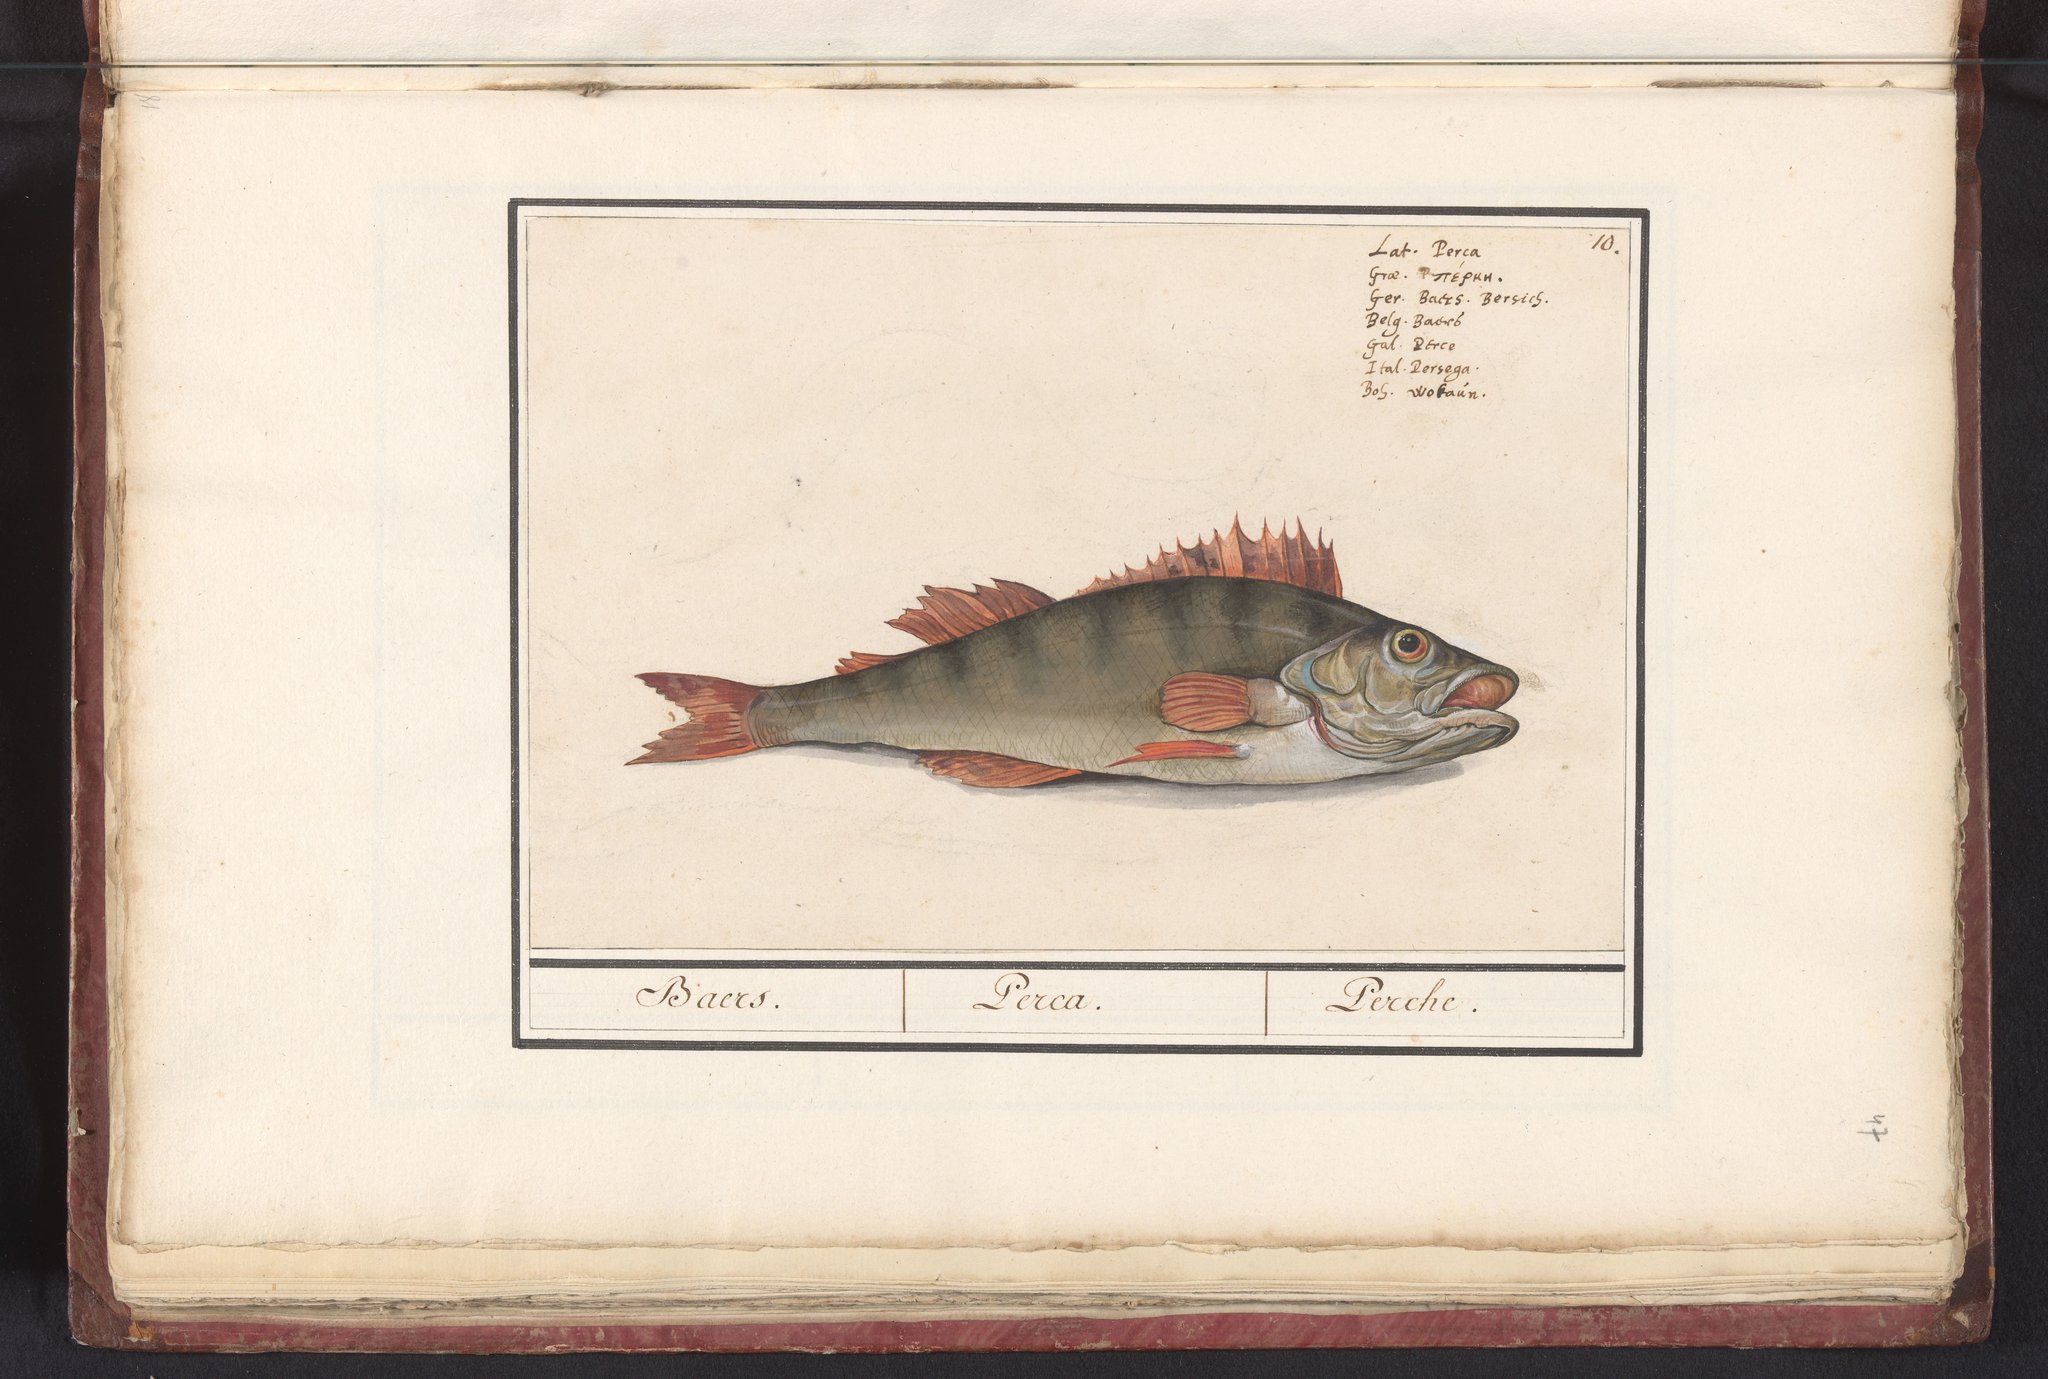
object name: drawing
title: Baers. / Perca. / Perche.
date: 1596-1610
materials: chalk, paint, ink, lacquer, paper, pencil, watercolor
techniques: brush, pen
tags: bony fishes: perch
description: Baars. Genummerd rechtsboven: 10. Hier ook de naam in zeven talen. Onderdeel van het zesde album met tekeningen van vissen, schelpen en insekten. Zesde van twaalf albums met tekeningen van dieren, vogels en planten bekend rond 1600, gemaakt in opdracht van keizer Rudolf II. Met toelichting in Nederlands, Latijn en Frans.